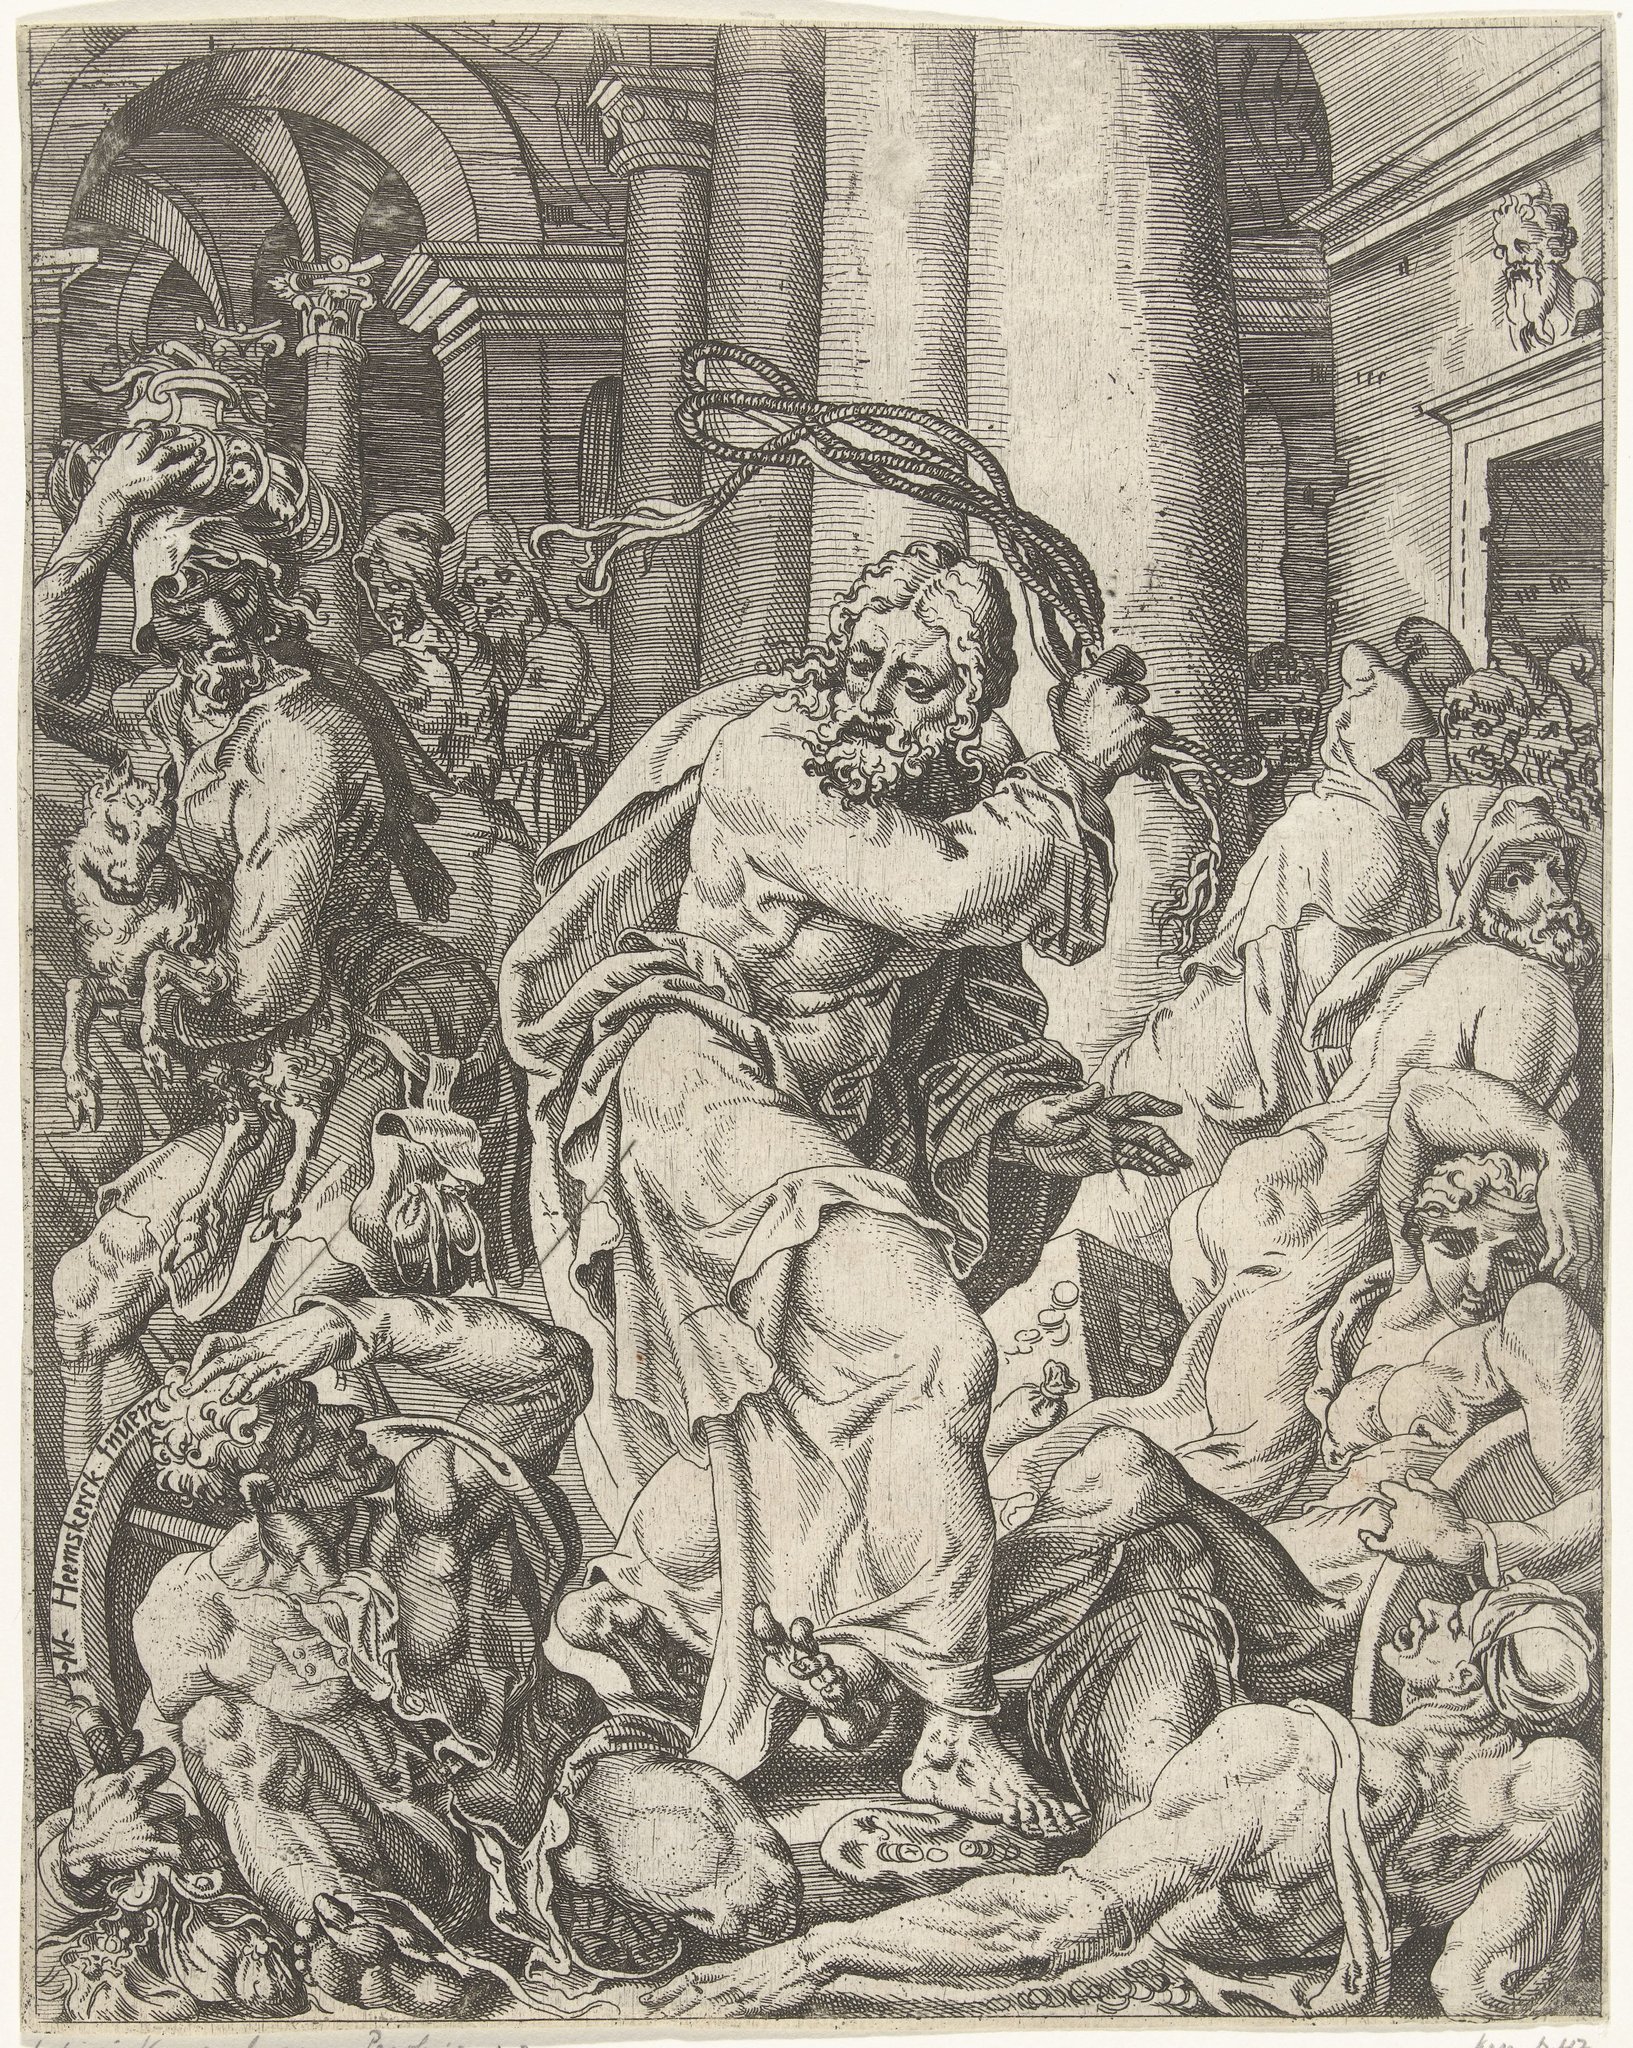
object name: print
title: Verdrijving van de geldwisselaars uit de tempel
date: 1548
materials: paper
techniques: etching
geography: haarlem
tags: purification of the temple ('first' and 'second'): christ driving the money-changers from the temple with a whip (matthew 21:12-13; mark 11:15-17; luke 19:45-46; john 12:12-19)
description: Christus verjaagt handelaars en geldwisselaars uit de tempel met een zweep. De prent is deel van een dertigdelige serie met prenten over de zondeval en Christus' passie.